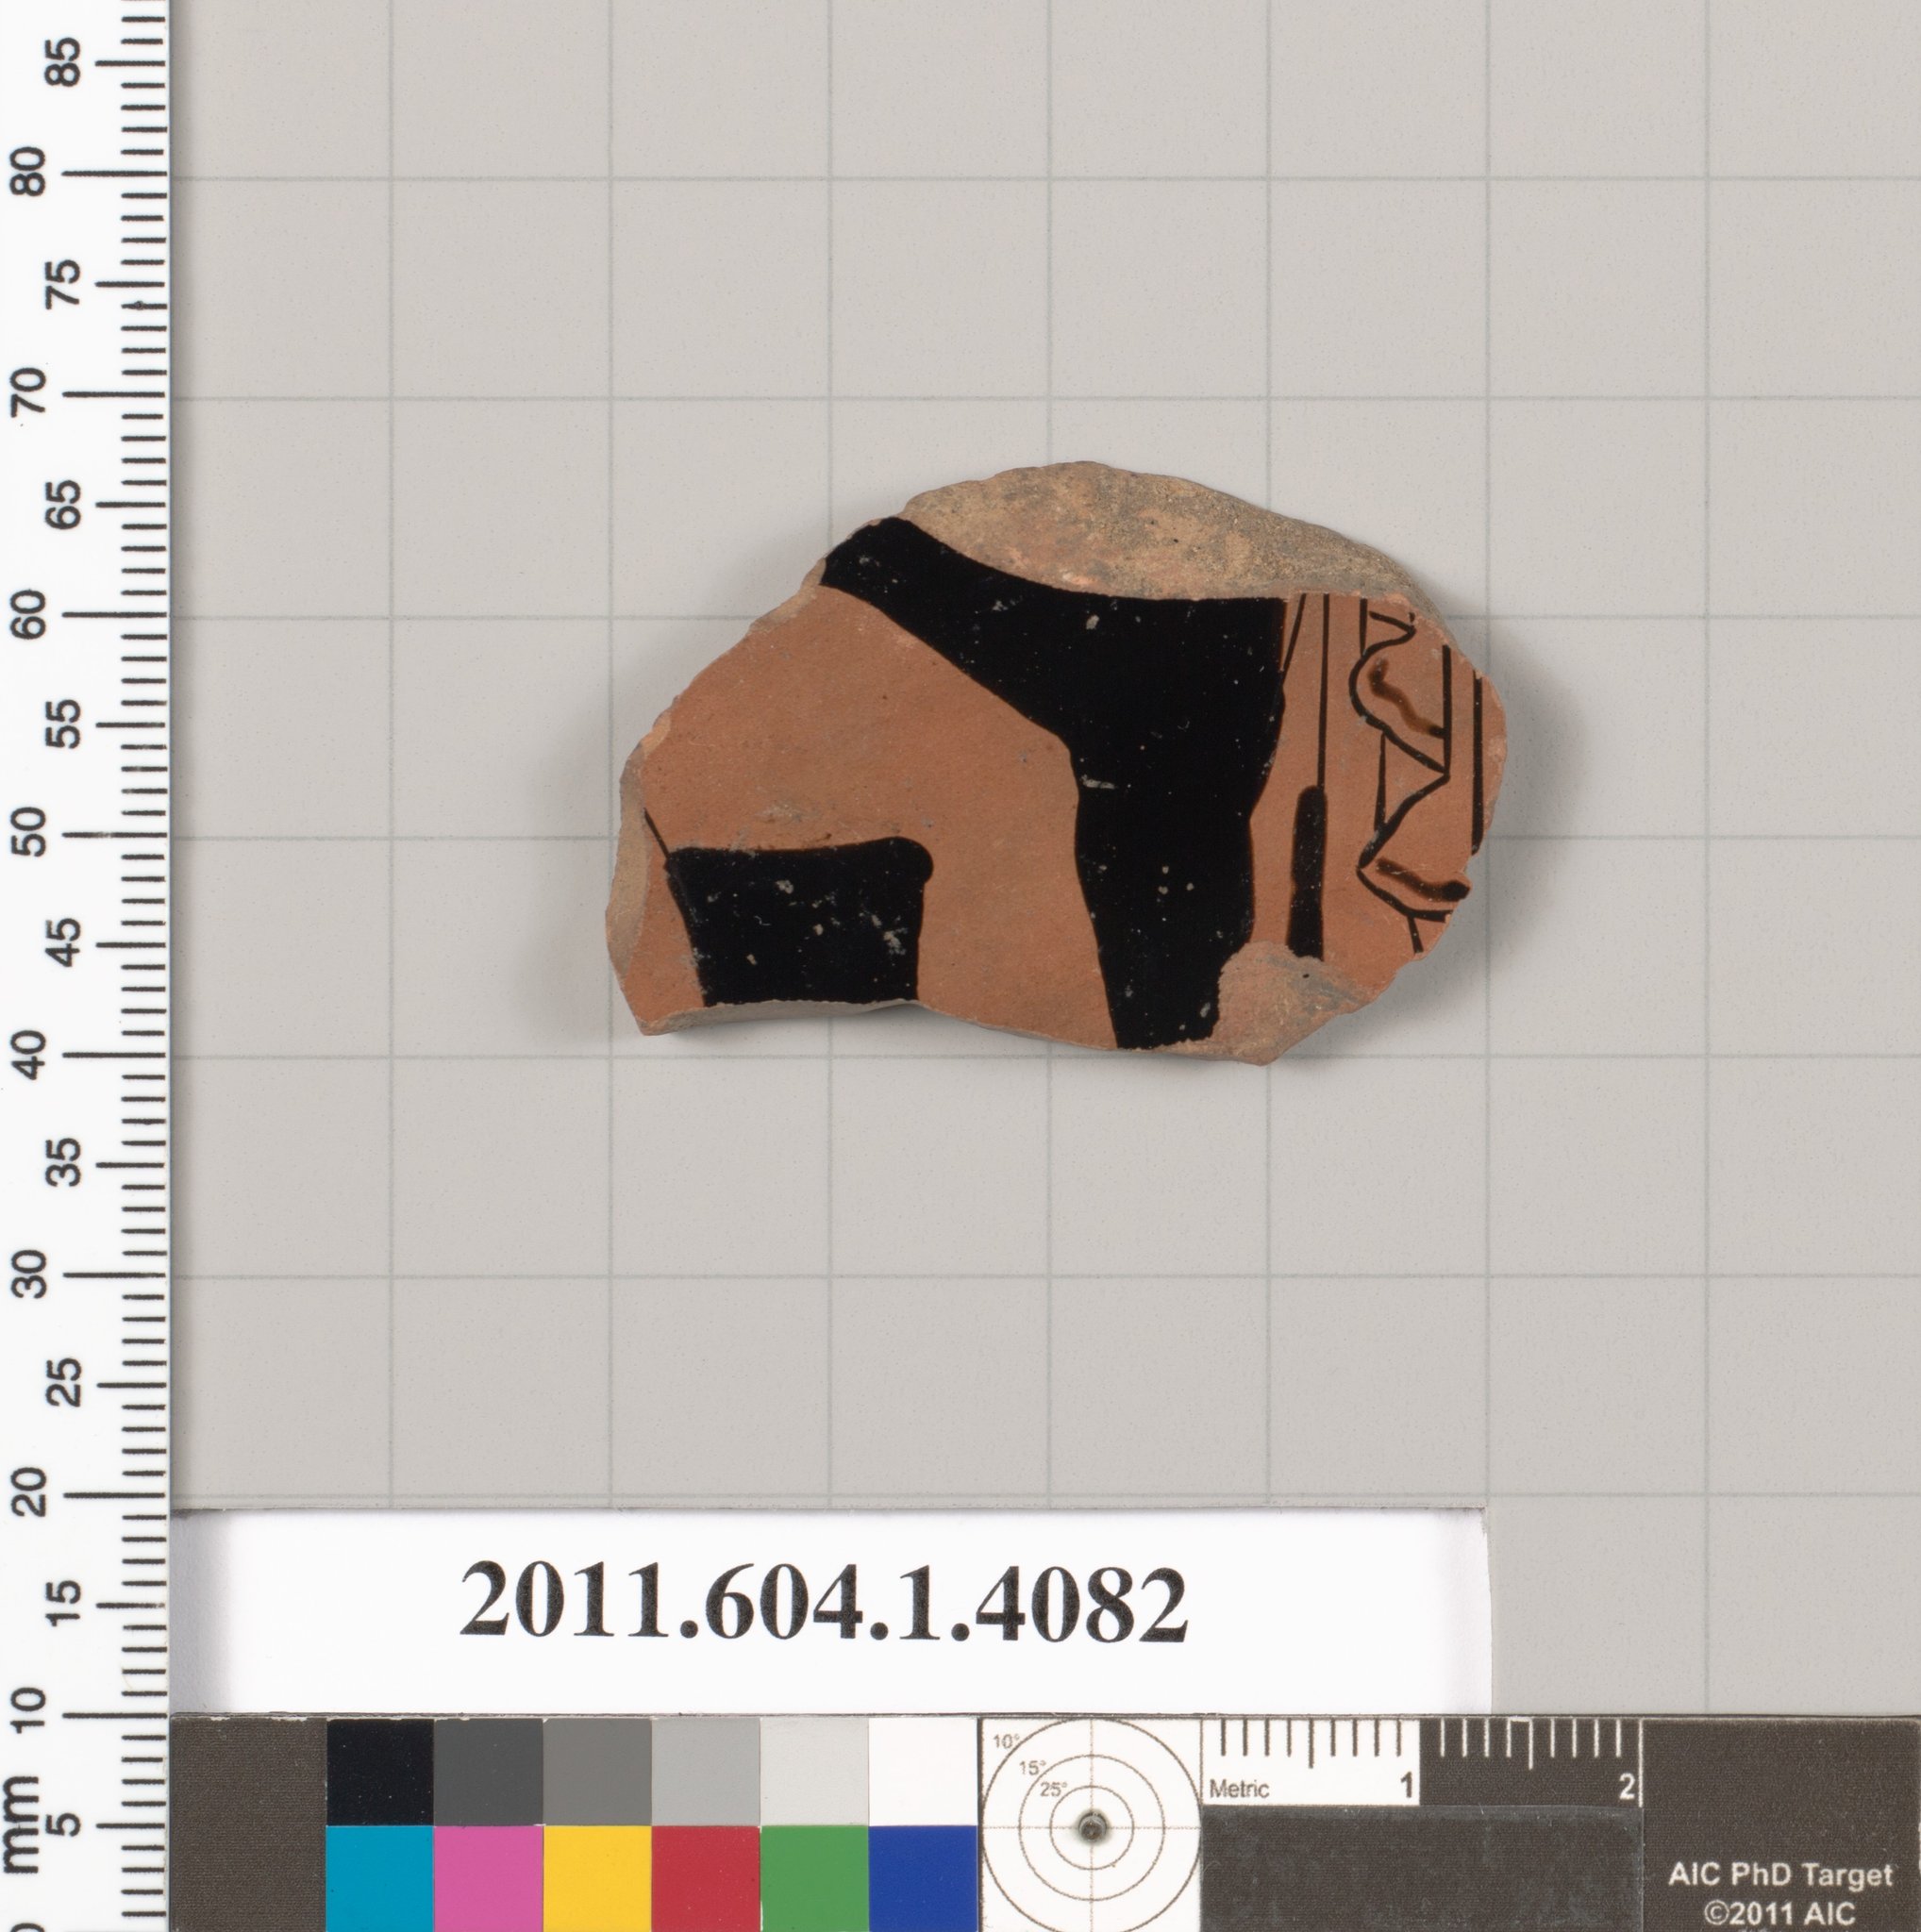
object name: kylix fragment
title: Terracotta fragment of a kylix (drinking cup)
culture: greek, attic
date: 510-490 BCE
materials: terracotta